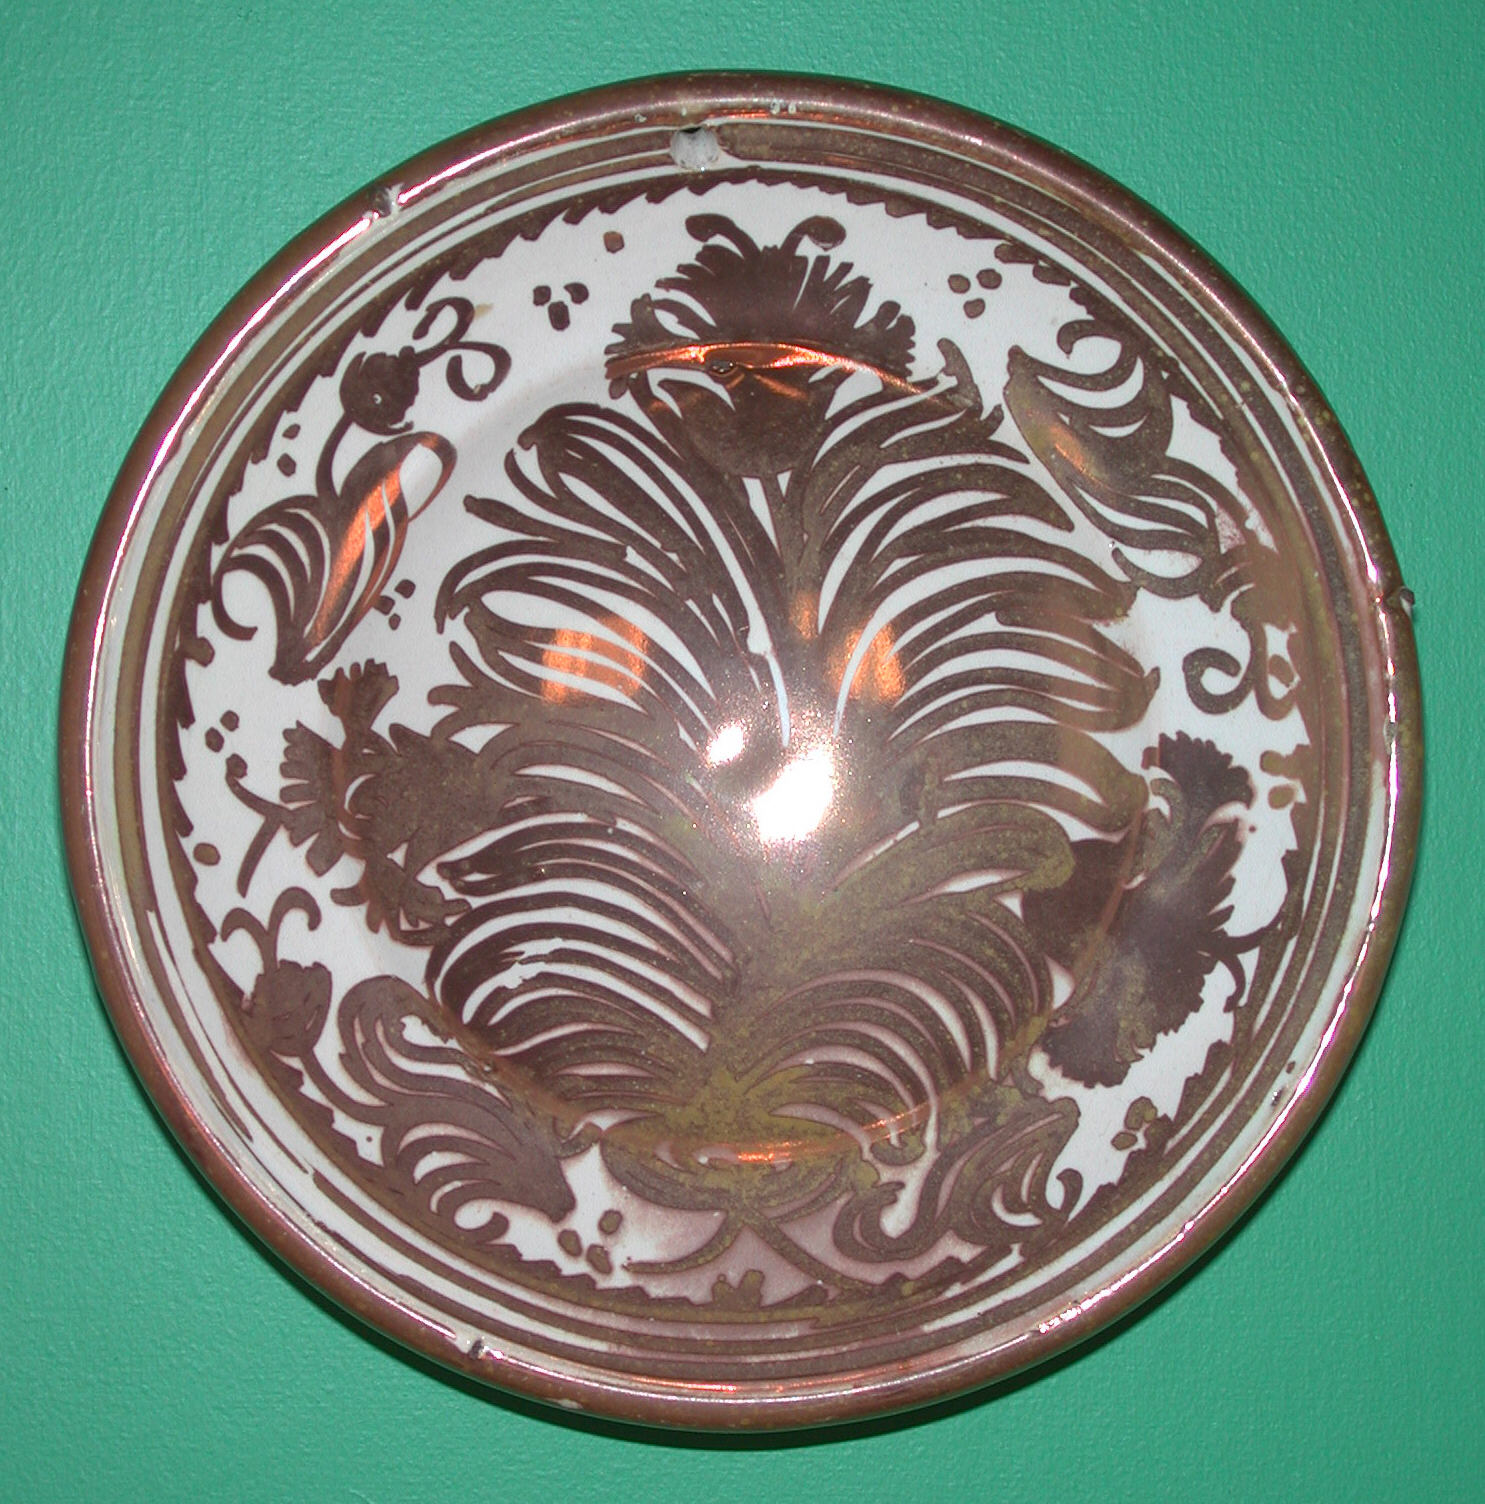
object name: dish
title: Pair of lustreware dishes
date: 1701-1900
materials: earthenware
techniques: glazing